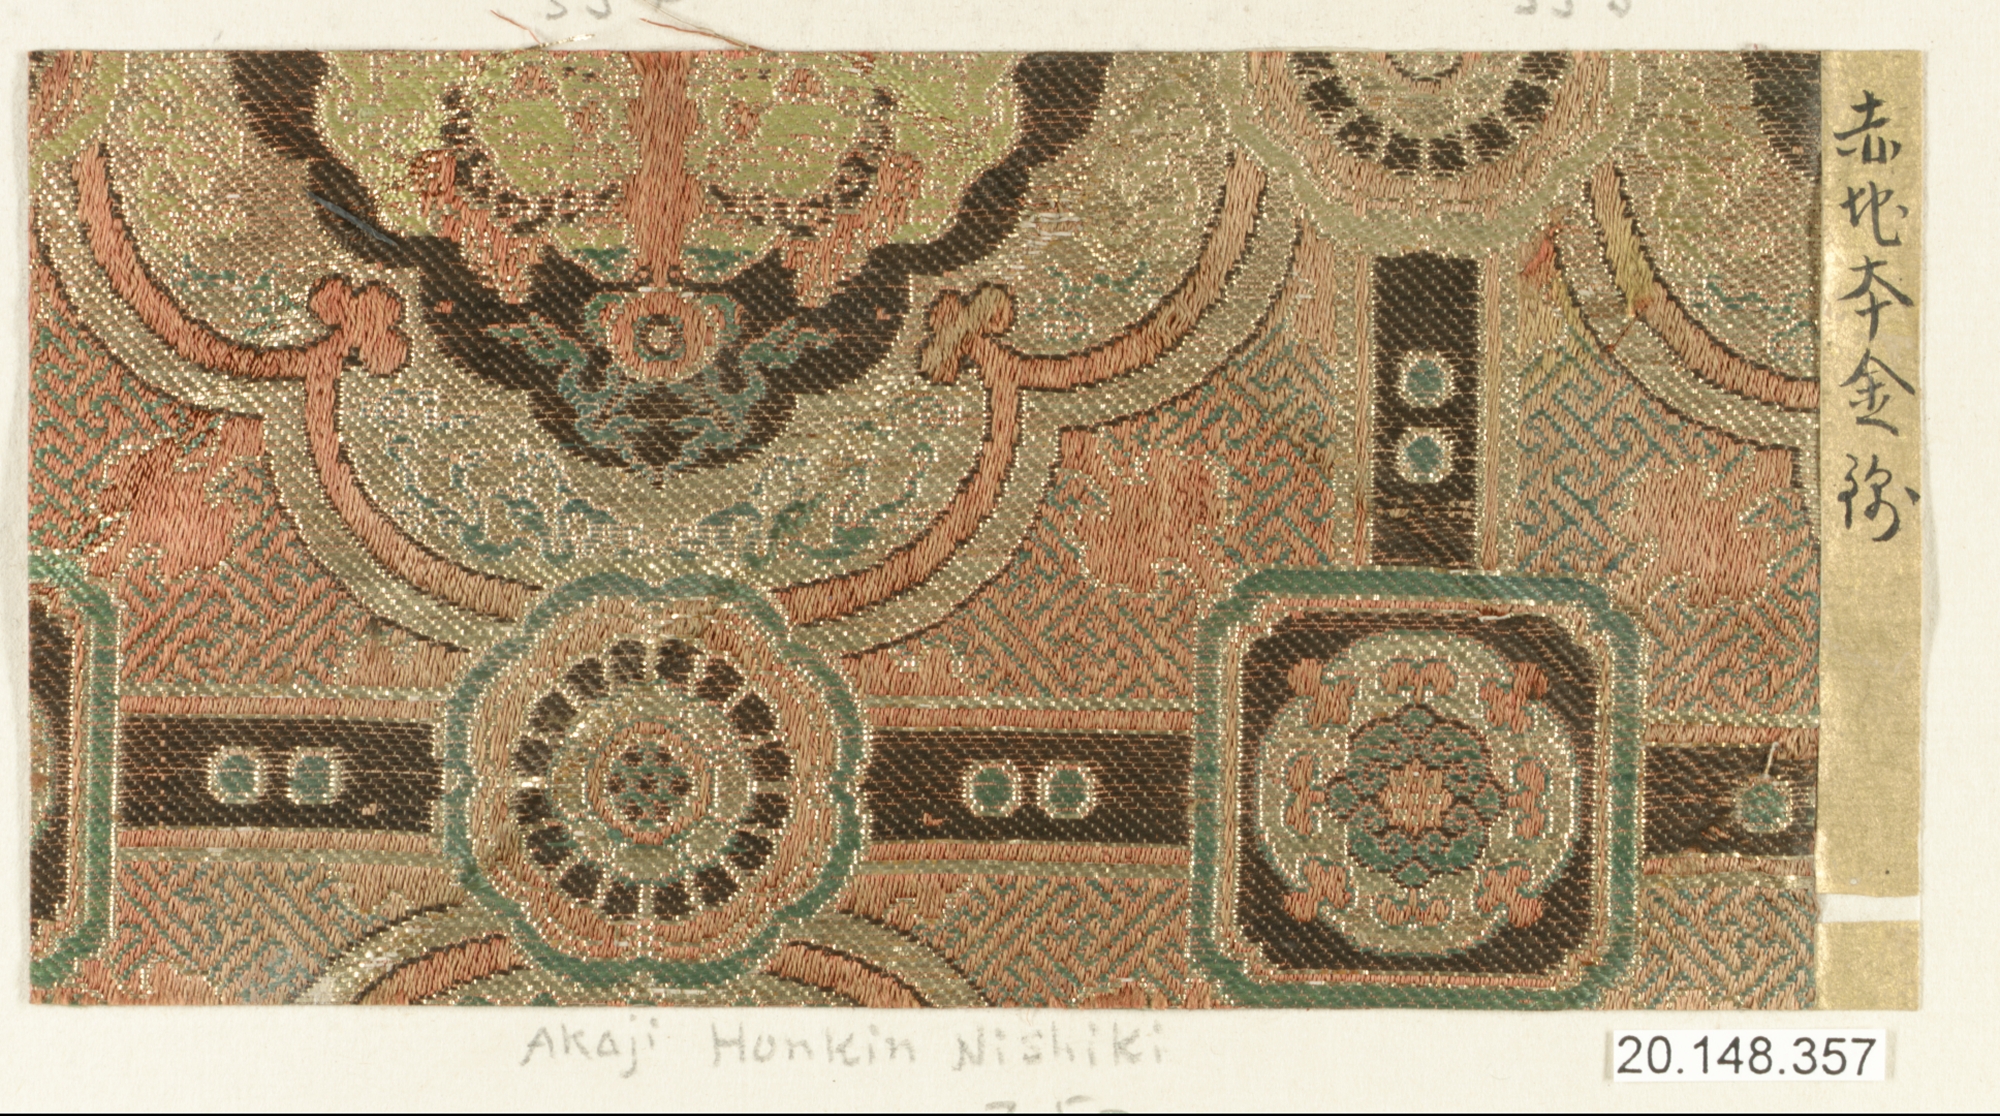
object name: piece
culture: japanese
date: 1601-1700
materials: silk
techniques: compound weave